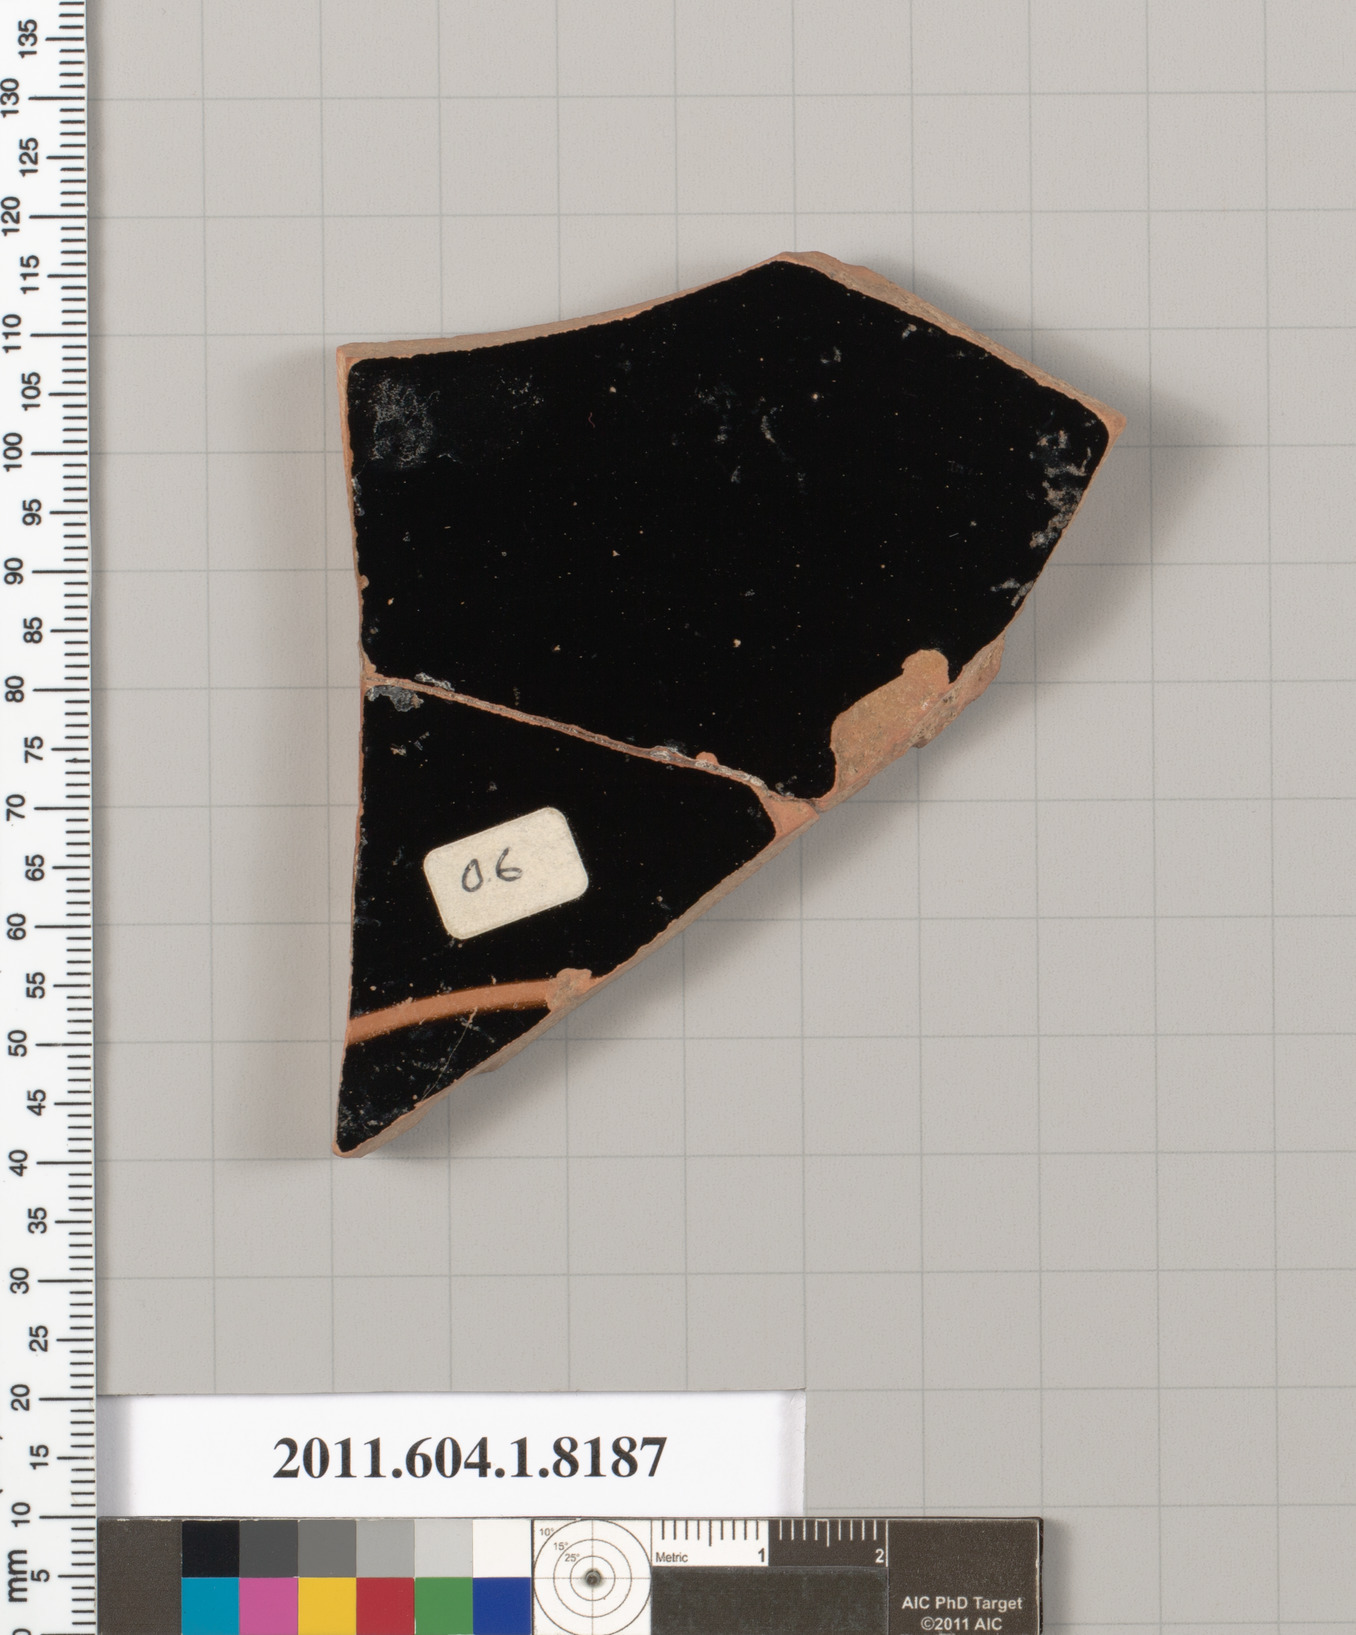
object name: kylix fragment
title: Terracotta fragment of a kylix (drinking cup)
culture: greek, attic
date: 520-510 BCE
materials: terracotta